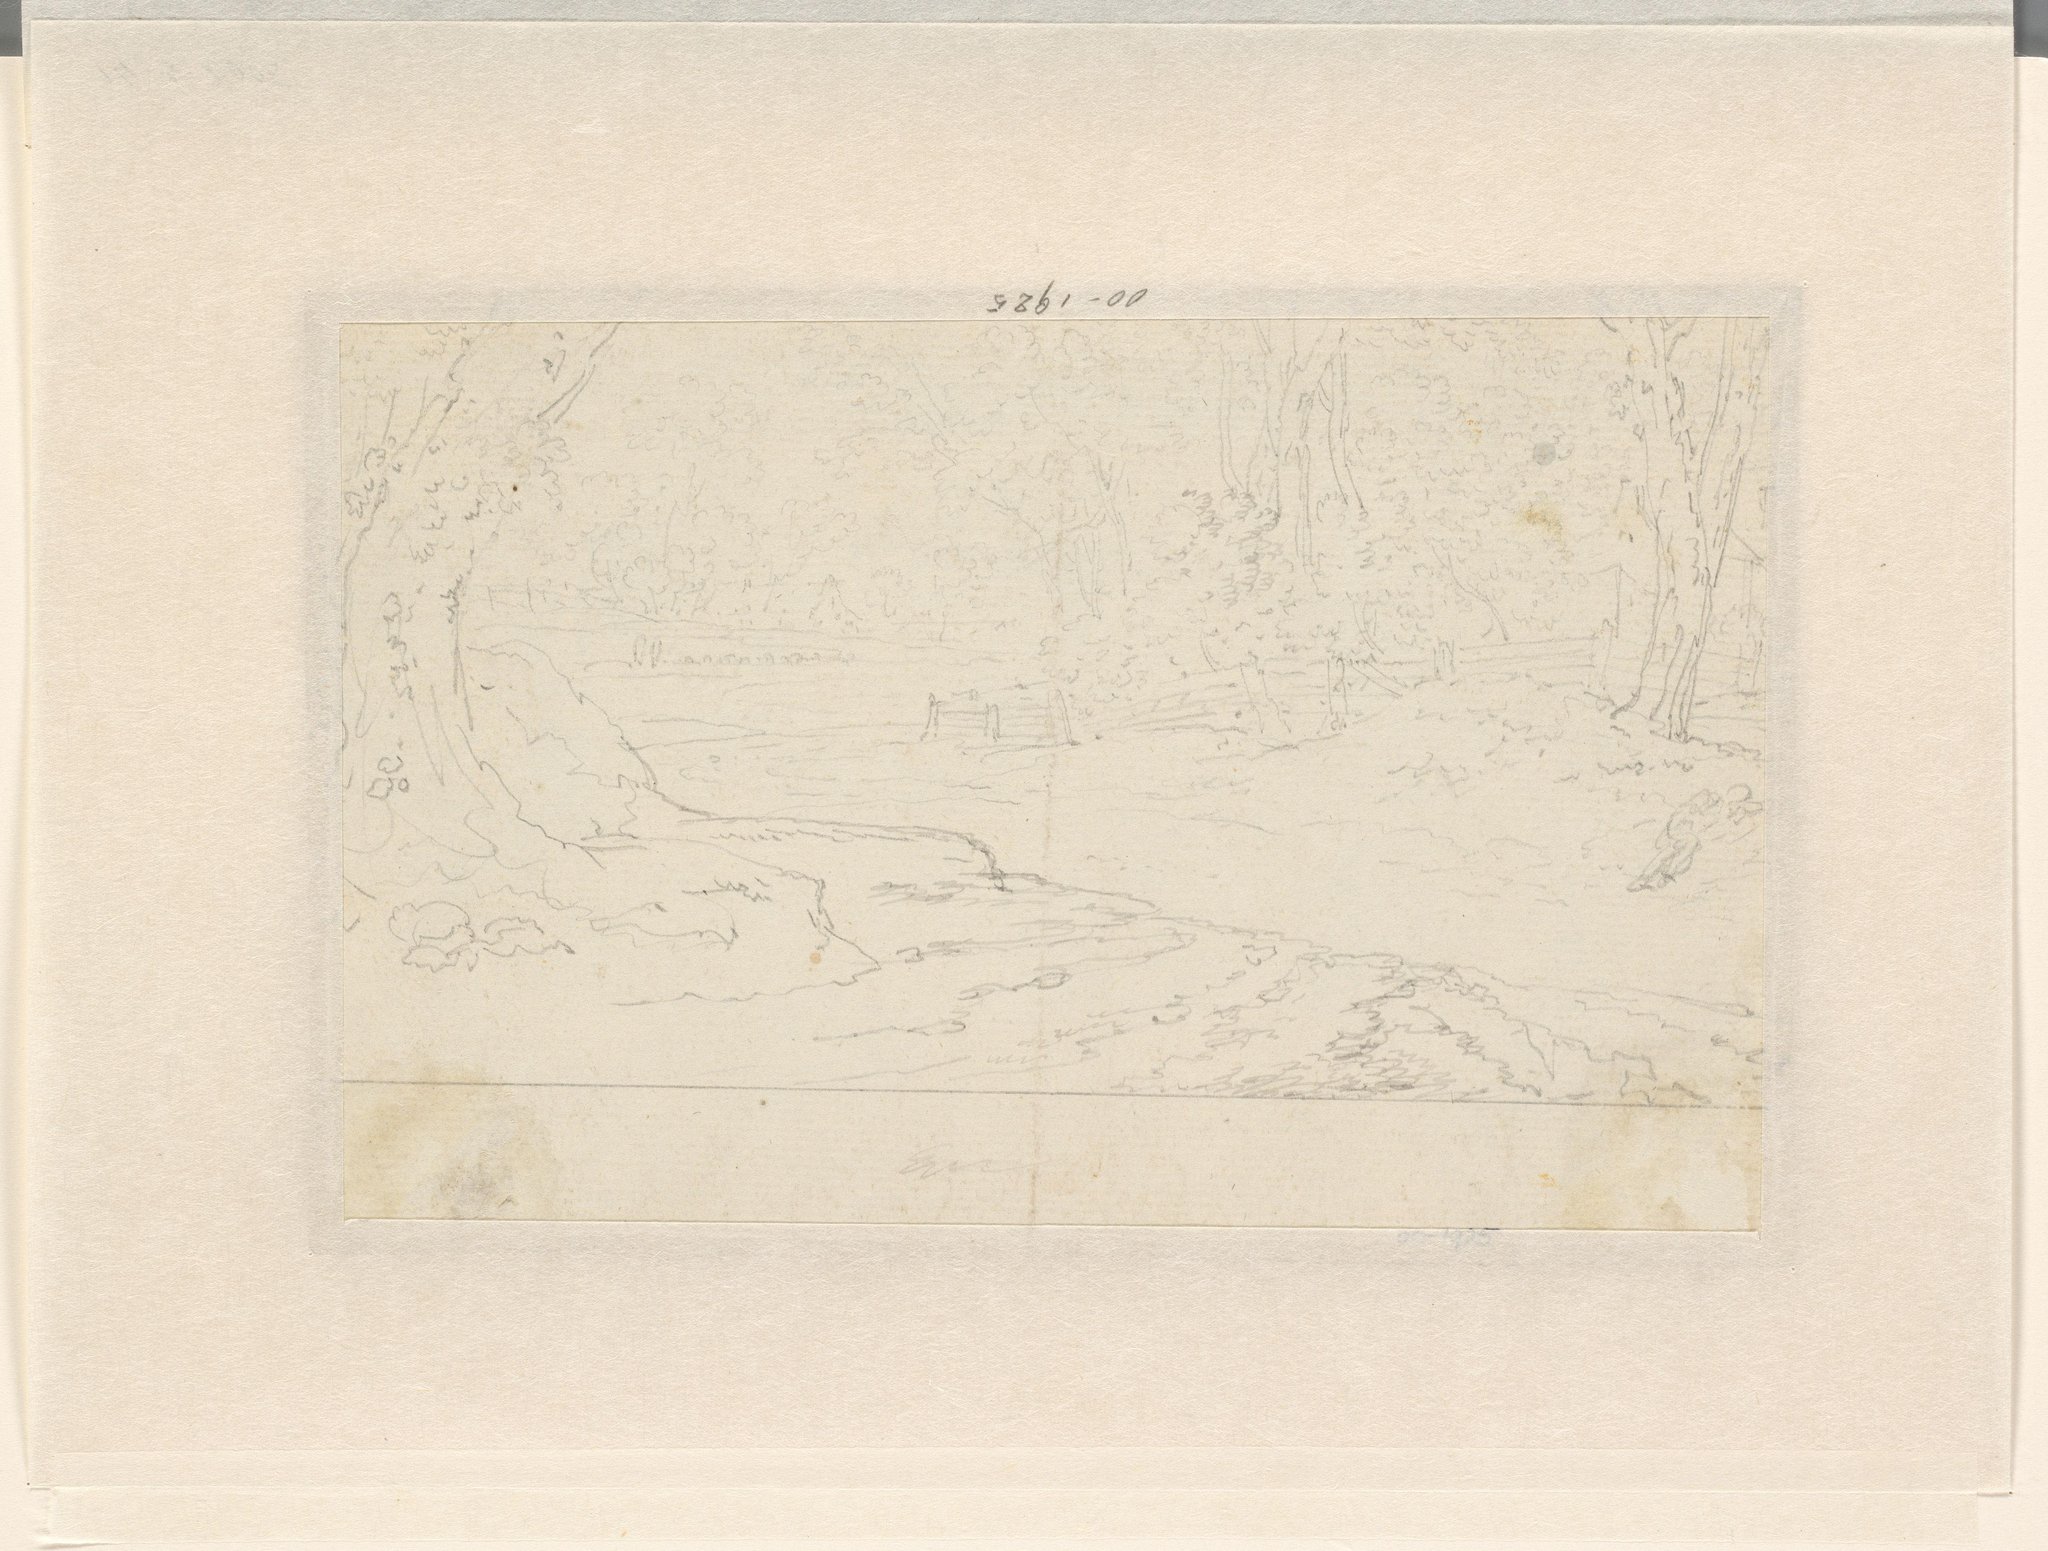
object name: drawing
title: Landschap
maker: Anonymous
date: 1700-1800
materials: paper, pencil